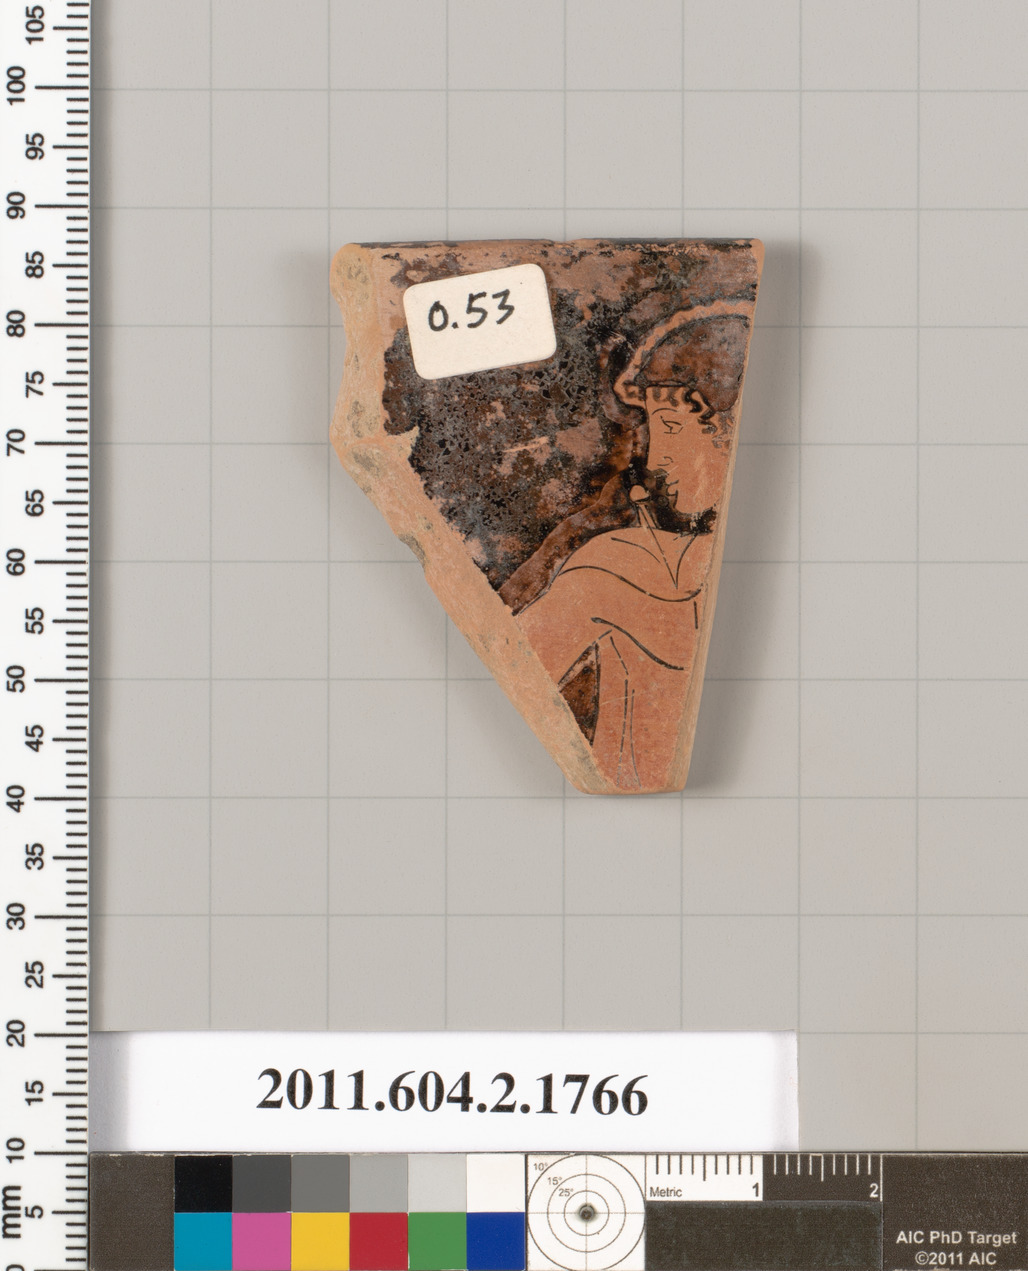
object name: skyphos fragment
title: Terracotta rim fragment of a skyphos (deep drinking cup)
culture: greek, attic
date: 470-450 BCE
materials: terracotta